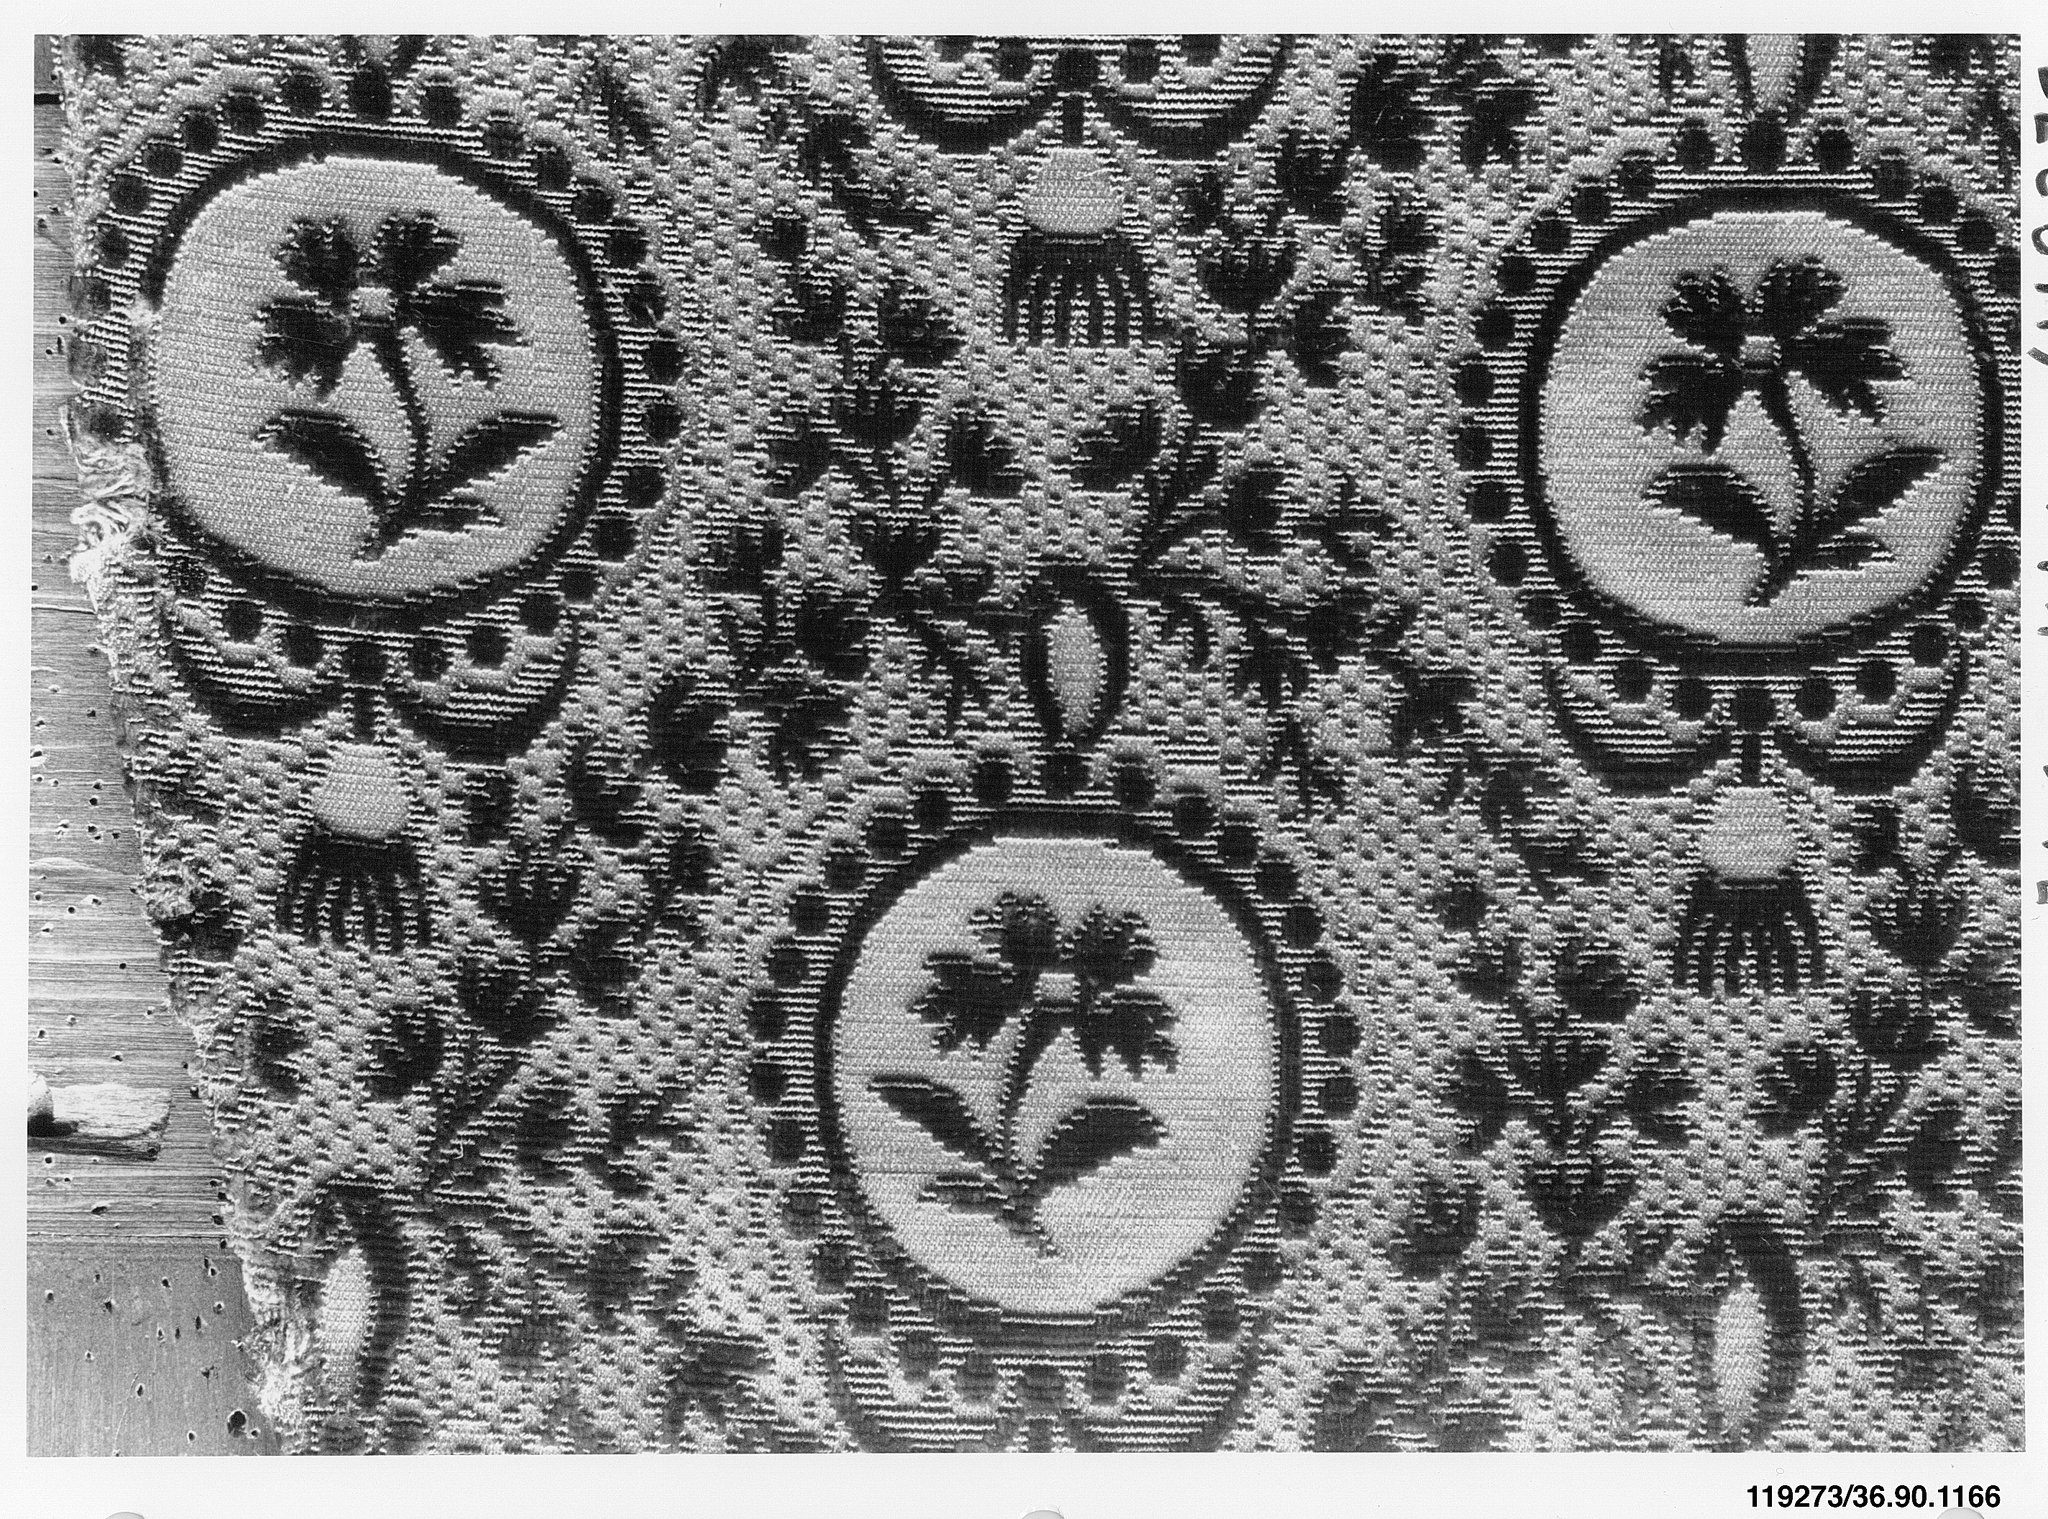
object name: piece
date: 1701-1800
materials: silk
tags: flowers,leaves